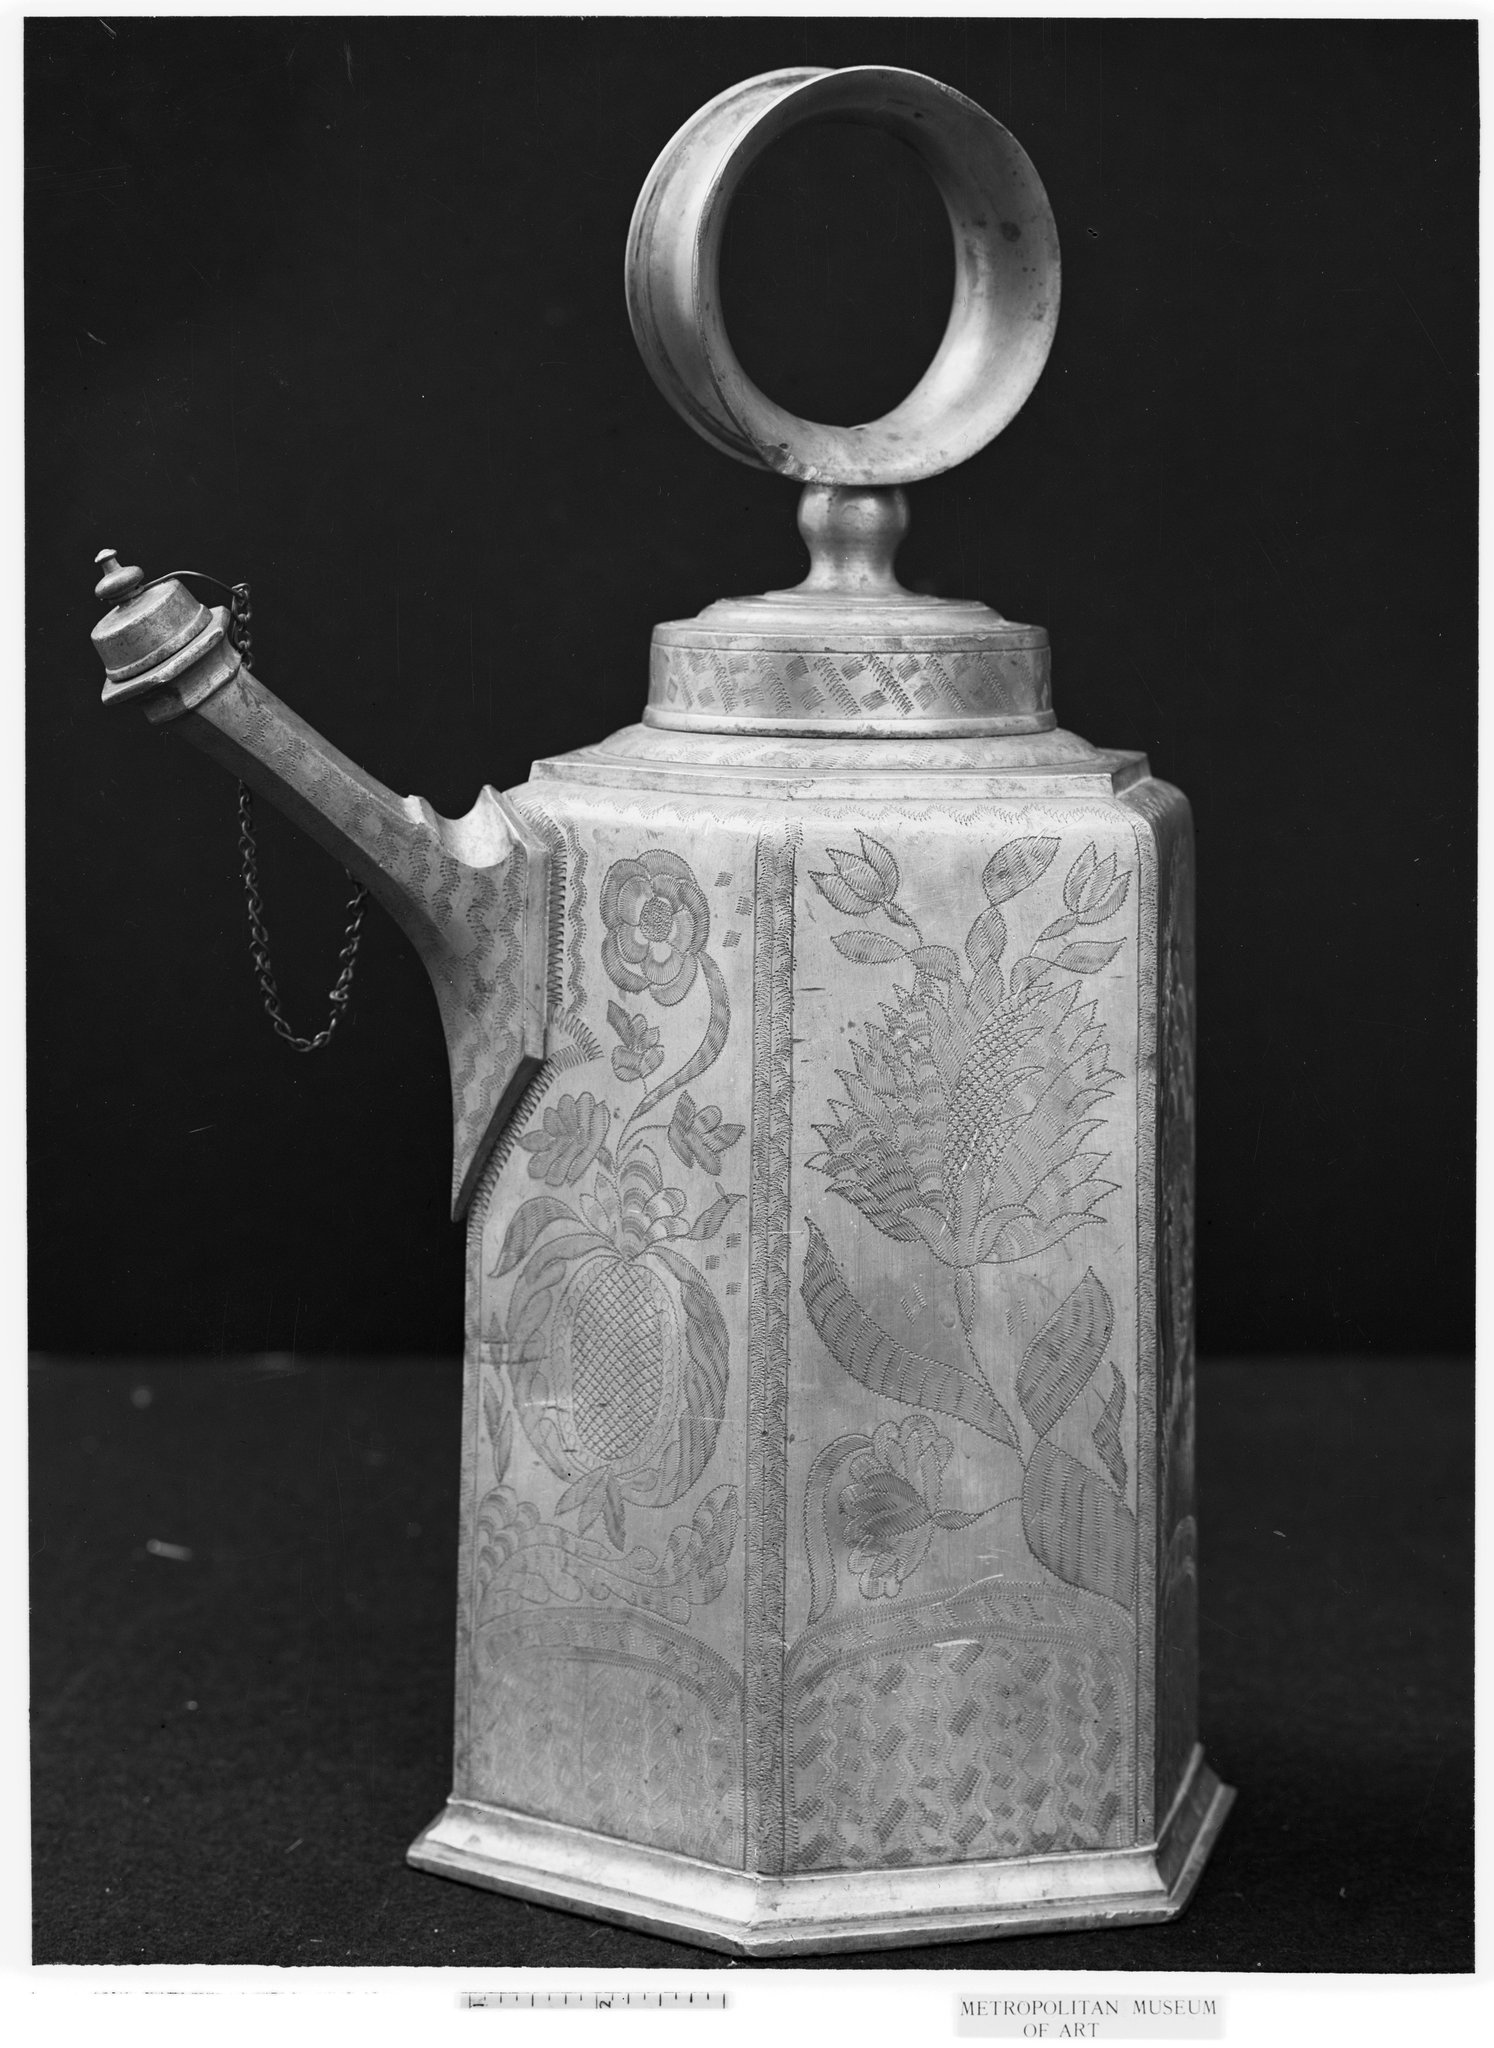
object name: milk or wine can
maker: johannes oder hans waeber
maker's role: maker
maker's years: 1713-1788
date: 1701-1800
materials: pewter